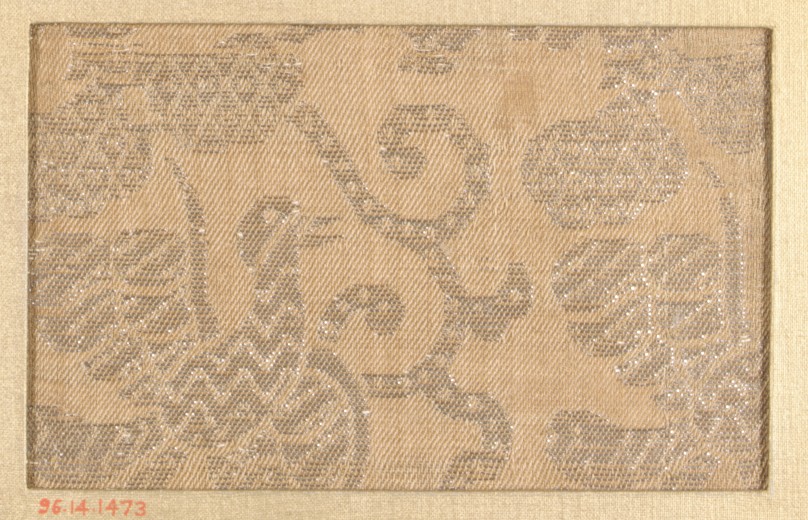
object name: piece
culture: japanese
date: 1701-1900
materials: silk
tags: birds